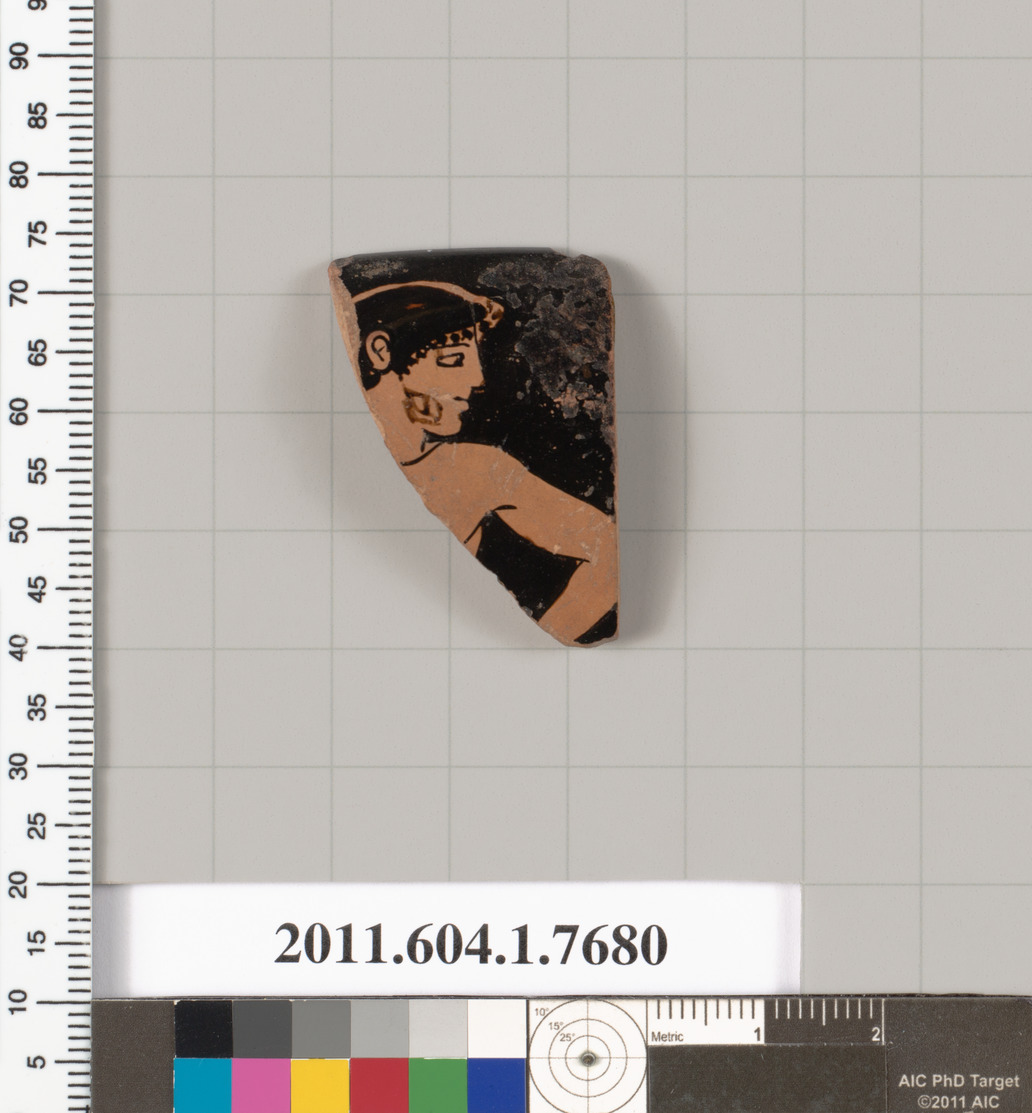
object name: kylix fragment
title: Terracotta rim fragment of a kylix (drinking cup)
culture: greek, attic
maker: boot painter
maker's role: artist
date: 480-470 BCE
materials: terracotta